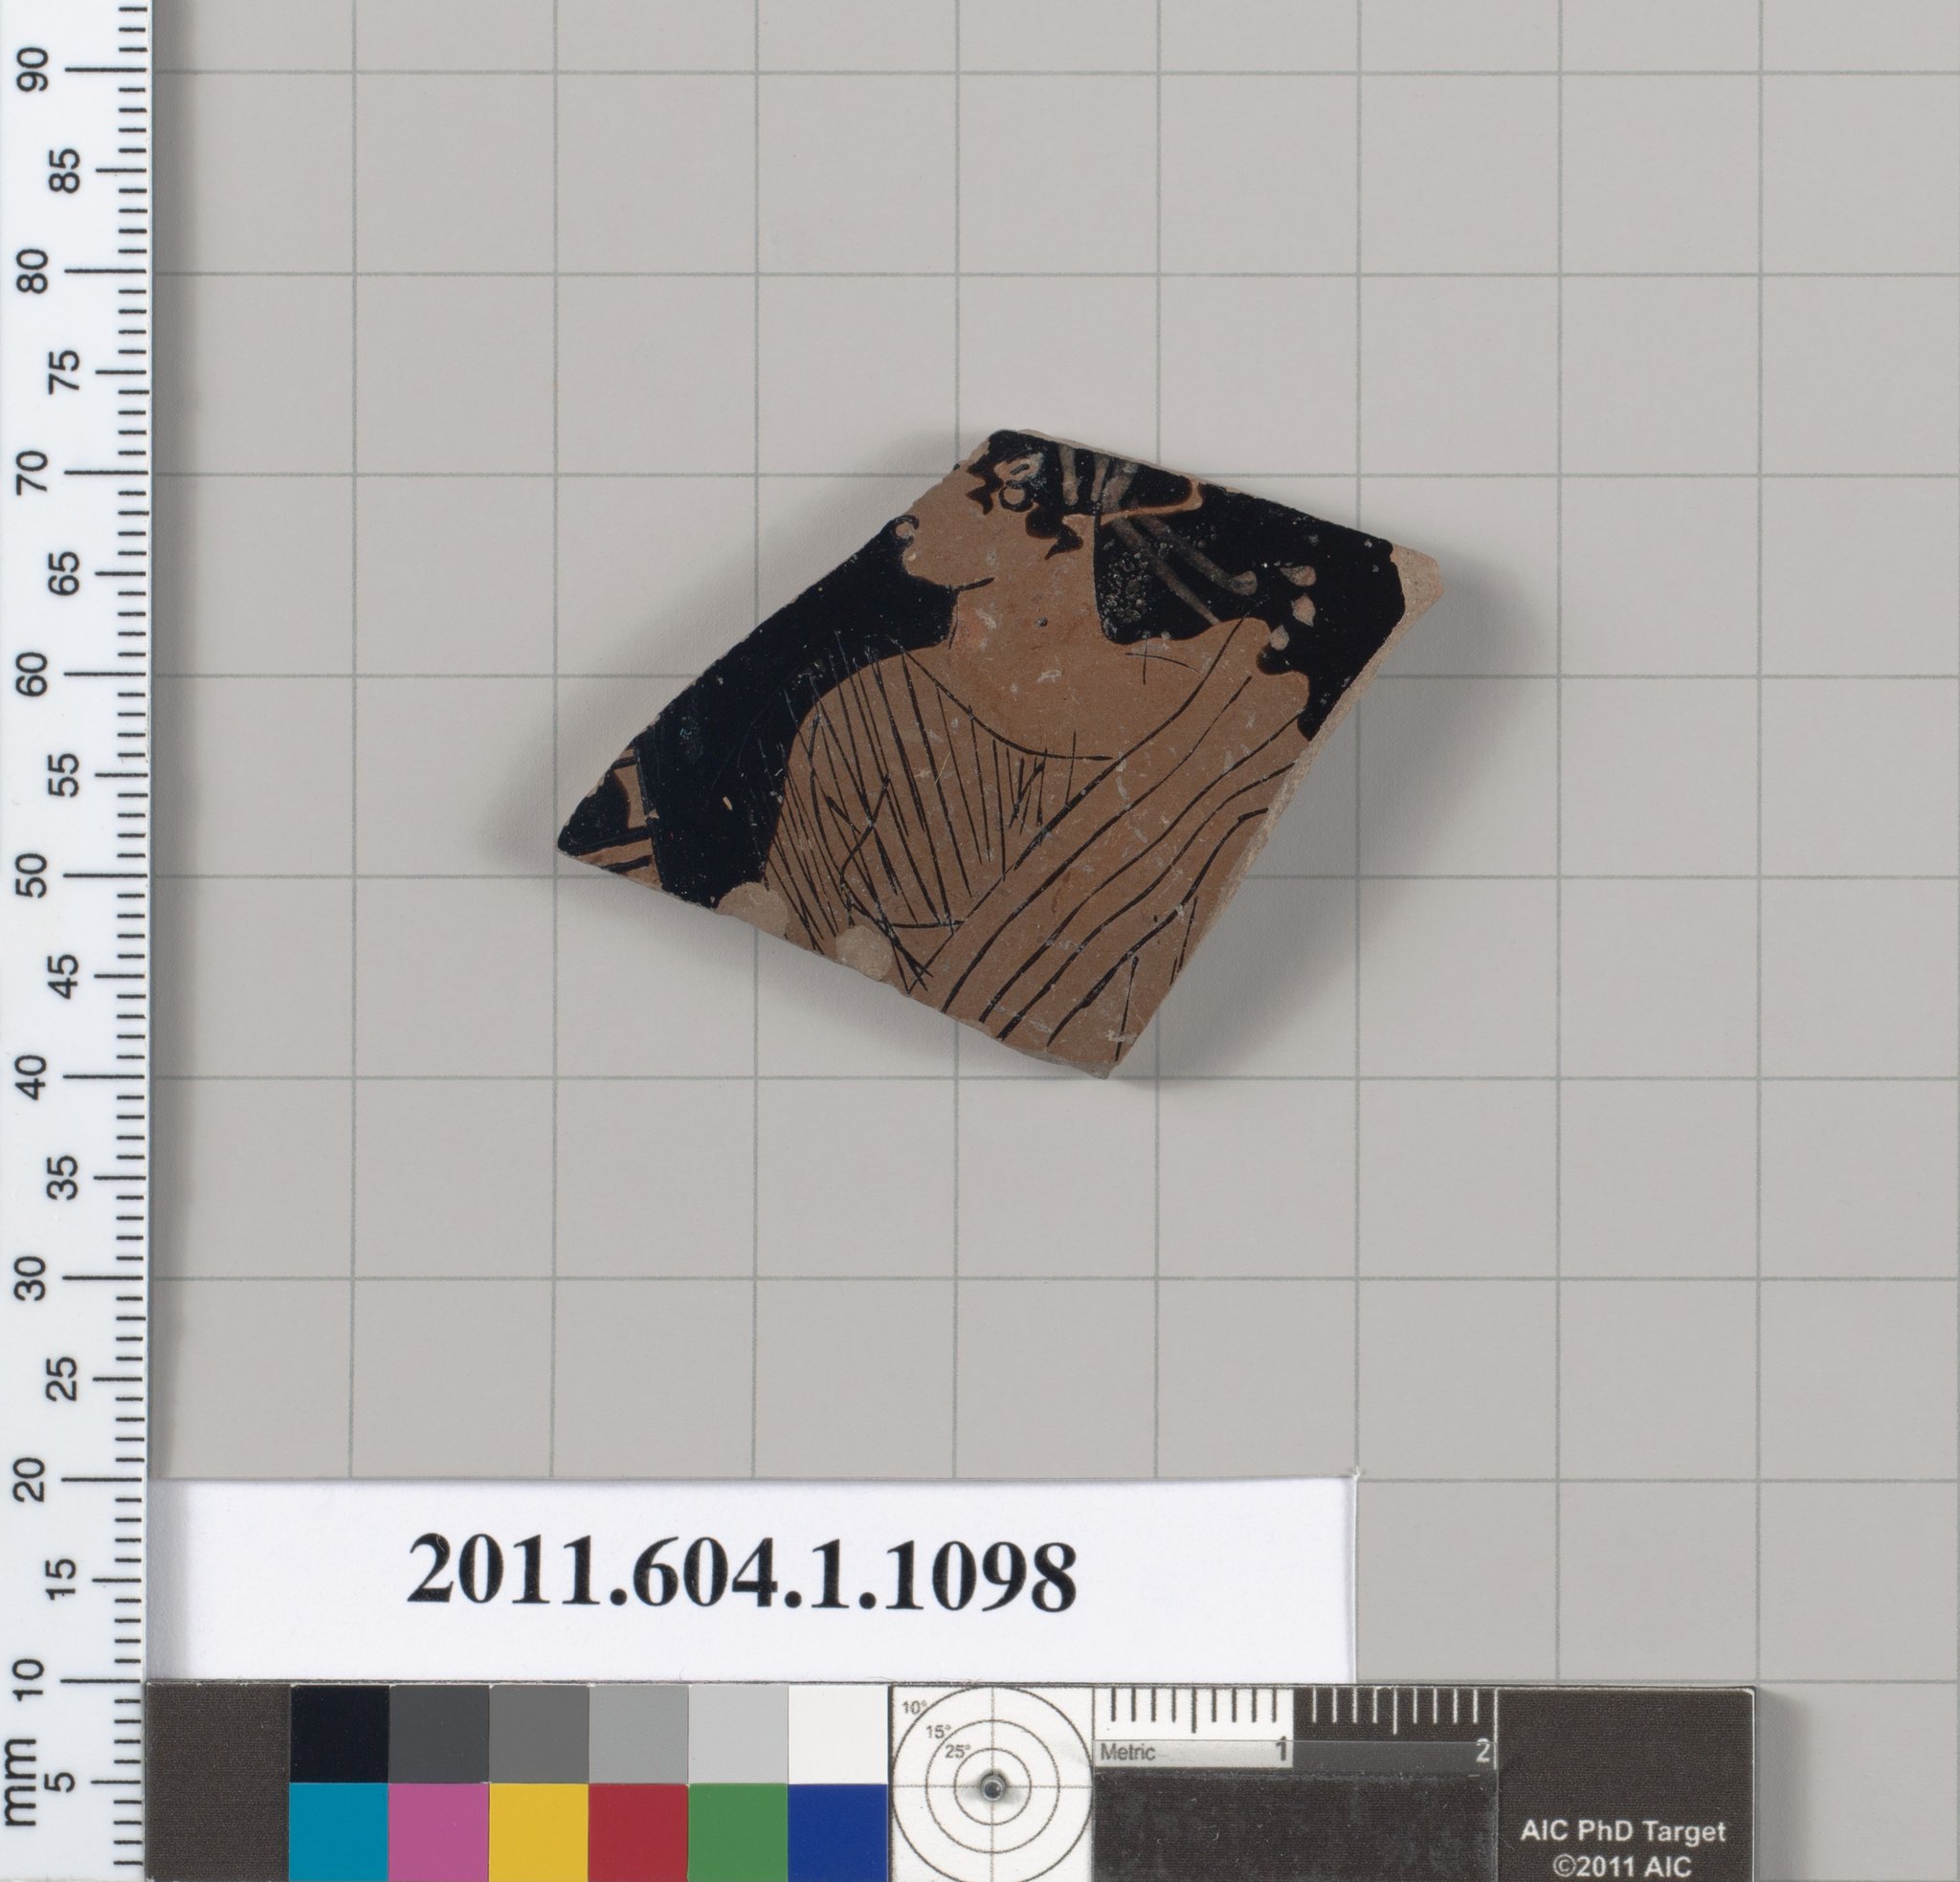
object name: kylix fragment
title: Terracotta fragment of a kylix (drinking cup)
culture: greek, attic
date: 475-451 BCE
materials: terracotta